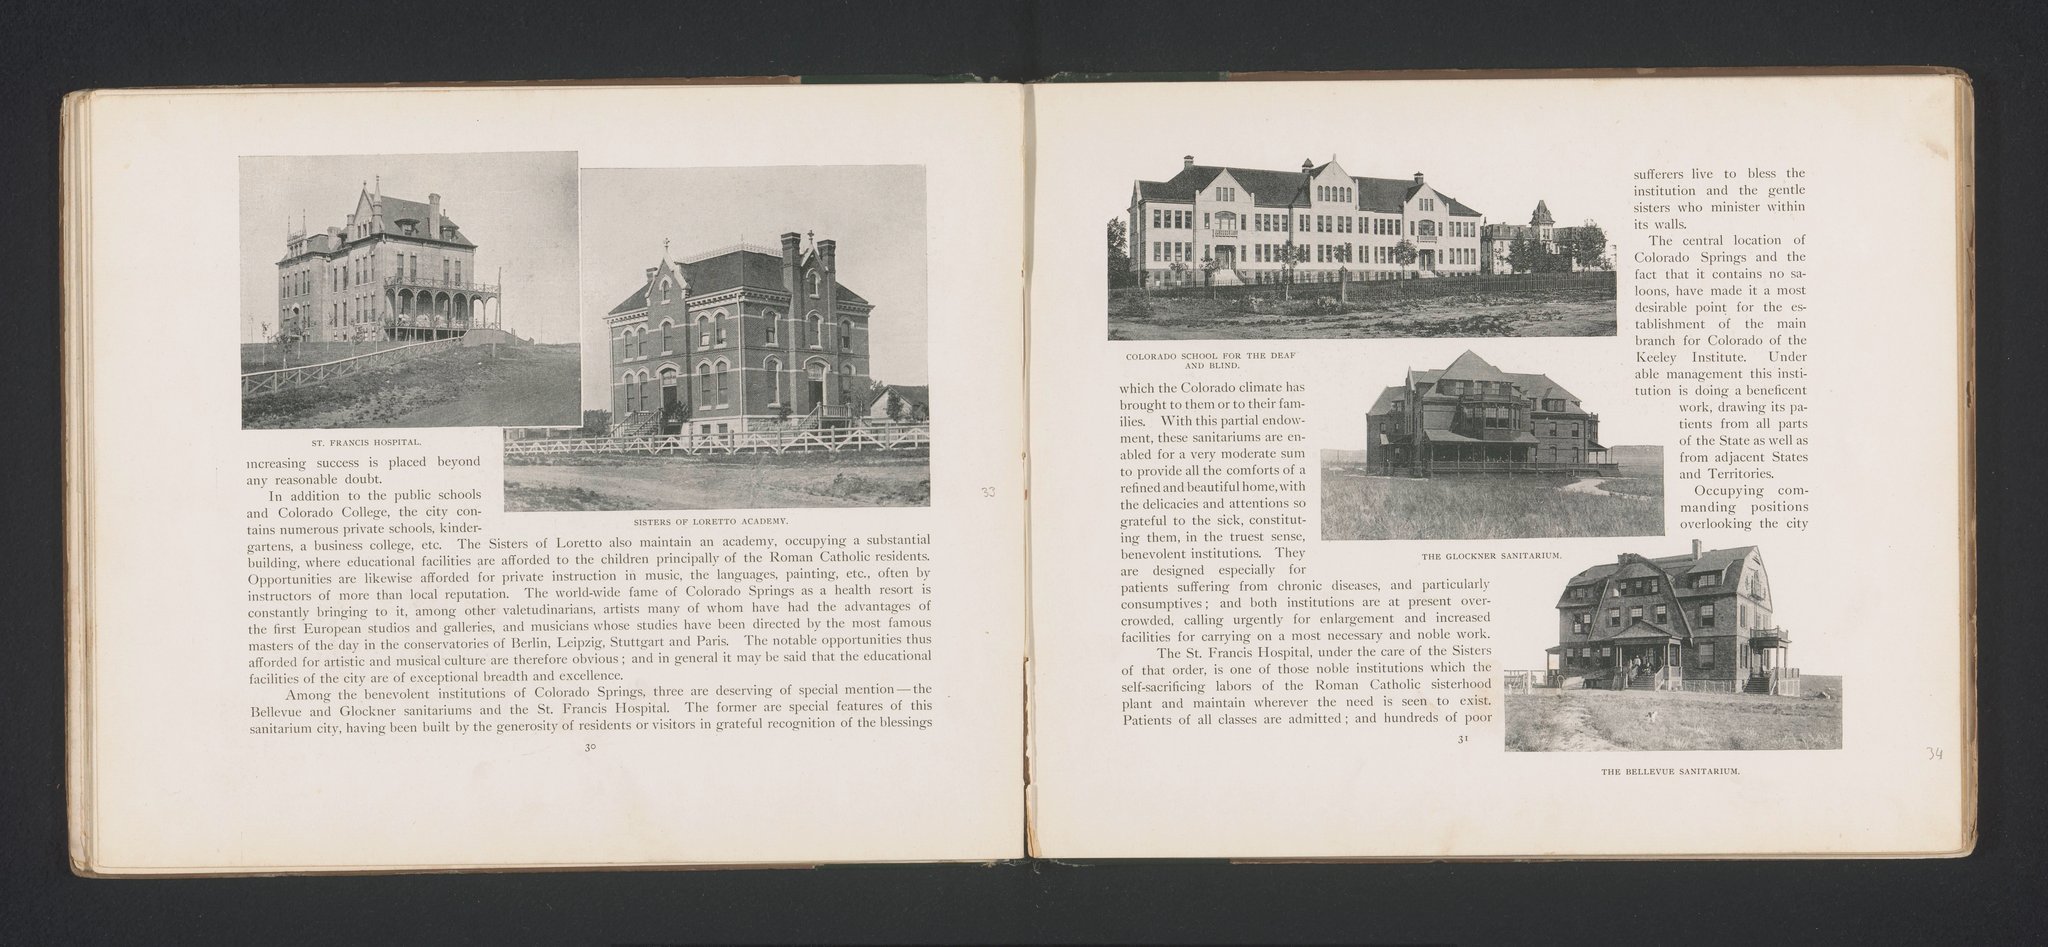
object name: page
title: Fotomontage van drie gebouwen in Colorado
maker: Anonymous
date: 1888-1893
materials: paper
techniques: autotype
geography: new york city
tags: specialized institutions, façade (of house or building)